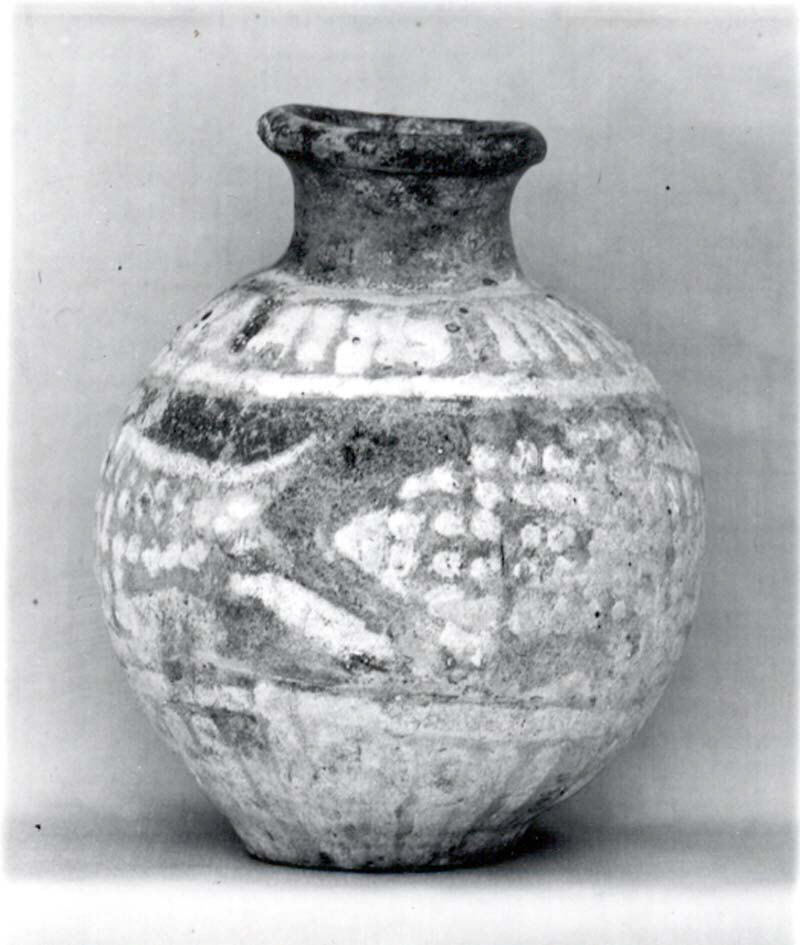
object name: jar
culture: parthian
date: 201-300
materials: ceramic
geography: iran